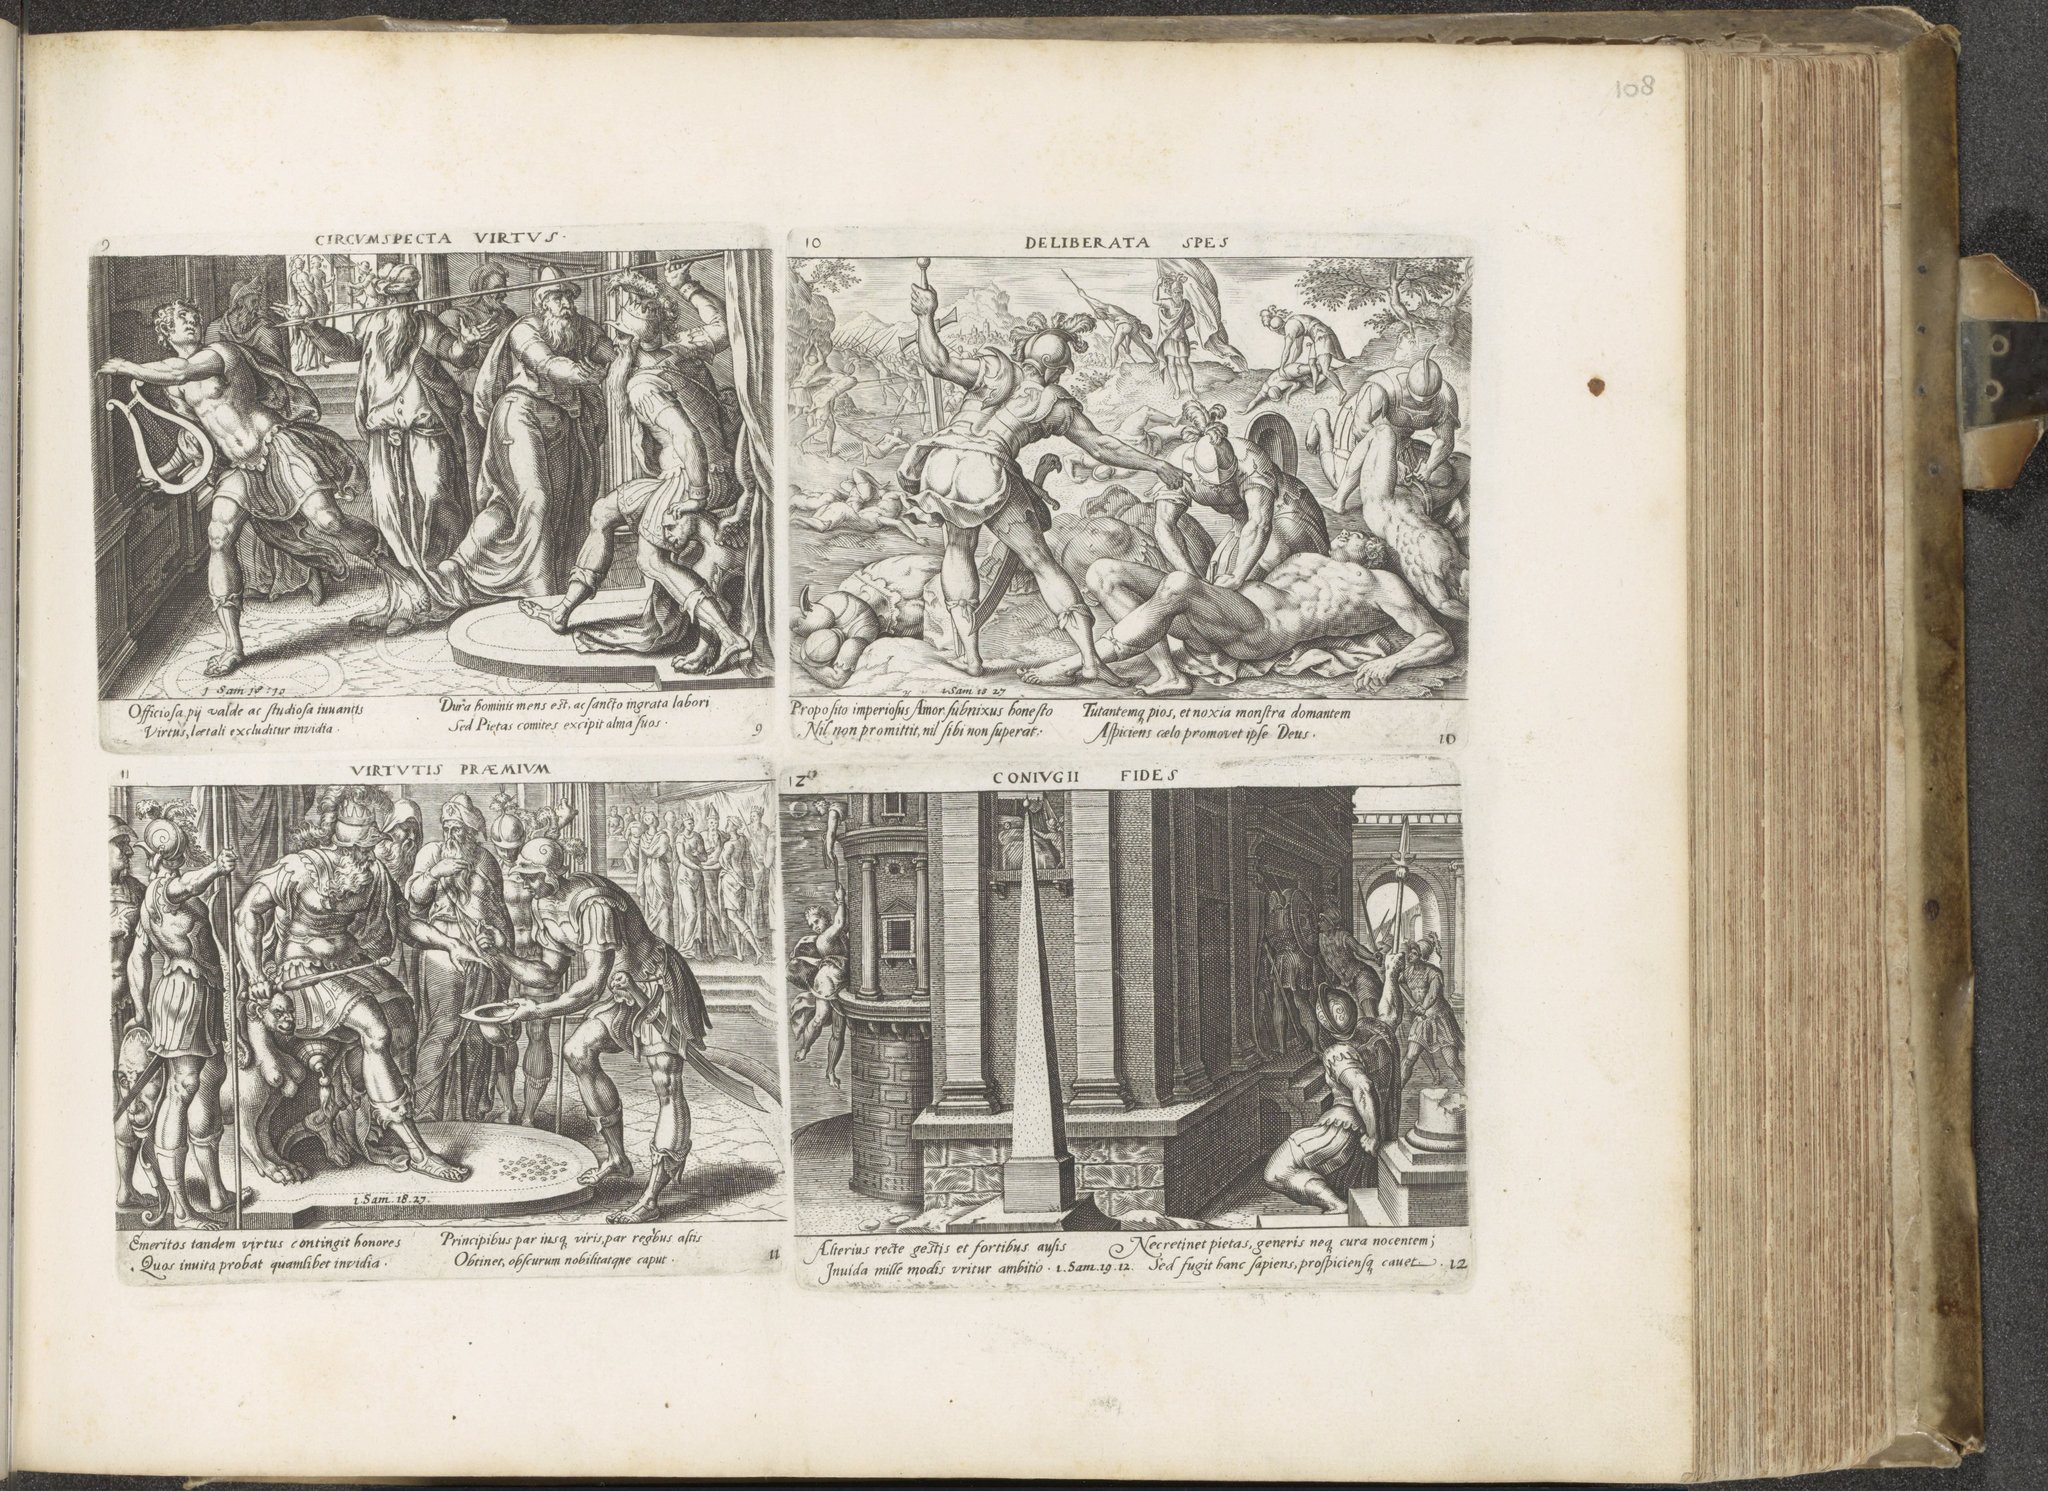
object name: print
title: Circumspecta virtus / Deliberata spes / Virtutis praemium / Conjughii fides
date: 1575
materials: paper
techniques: engraving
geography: amsterdam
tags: david kills two hundred philistines ~ his marriage with michal, david brings the foreskins of two hundred philistines to saul as dowry for michal, marriage of david and michal, story of david, saul casts his spear at david when the latter is playing his harp before the king (1 samuel 18:11), david escapes through a window; michal lets him down with the help of a rope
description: Vier voorstellingen op een albumblad over het leven van David, genummerd negen tot en met twaalf. Linksboven richt Saul uit jaloezie zijn speer op David en probeert hem te doden. Een dienaar probeert hem te stoppen. David rent weg met een harp in zijn handen. Rechtsboven doodt David tweehonderd Filistijnen. Hij liet hun voorhuiden verwijderen en bracht ze als bruidsschat aan koning Saul, afgebeeld op de prent linksonder. Op de achtergrond van deze voorstelling geeft Saul David zijn dochter Michal tot vrouw. Rechtsonder helpt Michal David ontsnappen aan de soldaten van haar vader. David klimt vanuit het raam via een touw naar beneden. De soldaten staan voor de deur. Iedere voorstelling met een Latijns opschrift en vier regels Latijn in de ondermarge. Het blad maakt deel uit van een album.